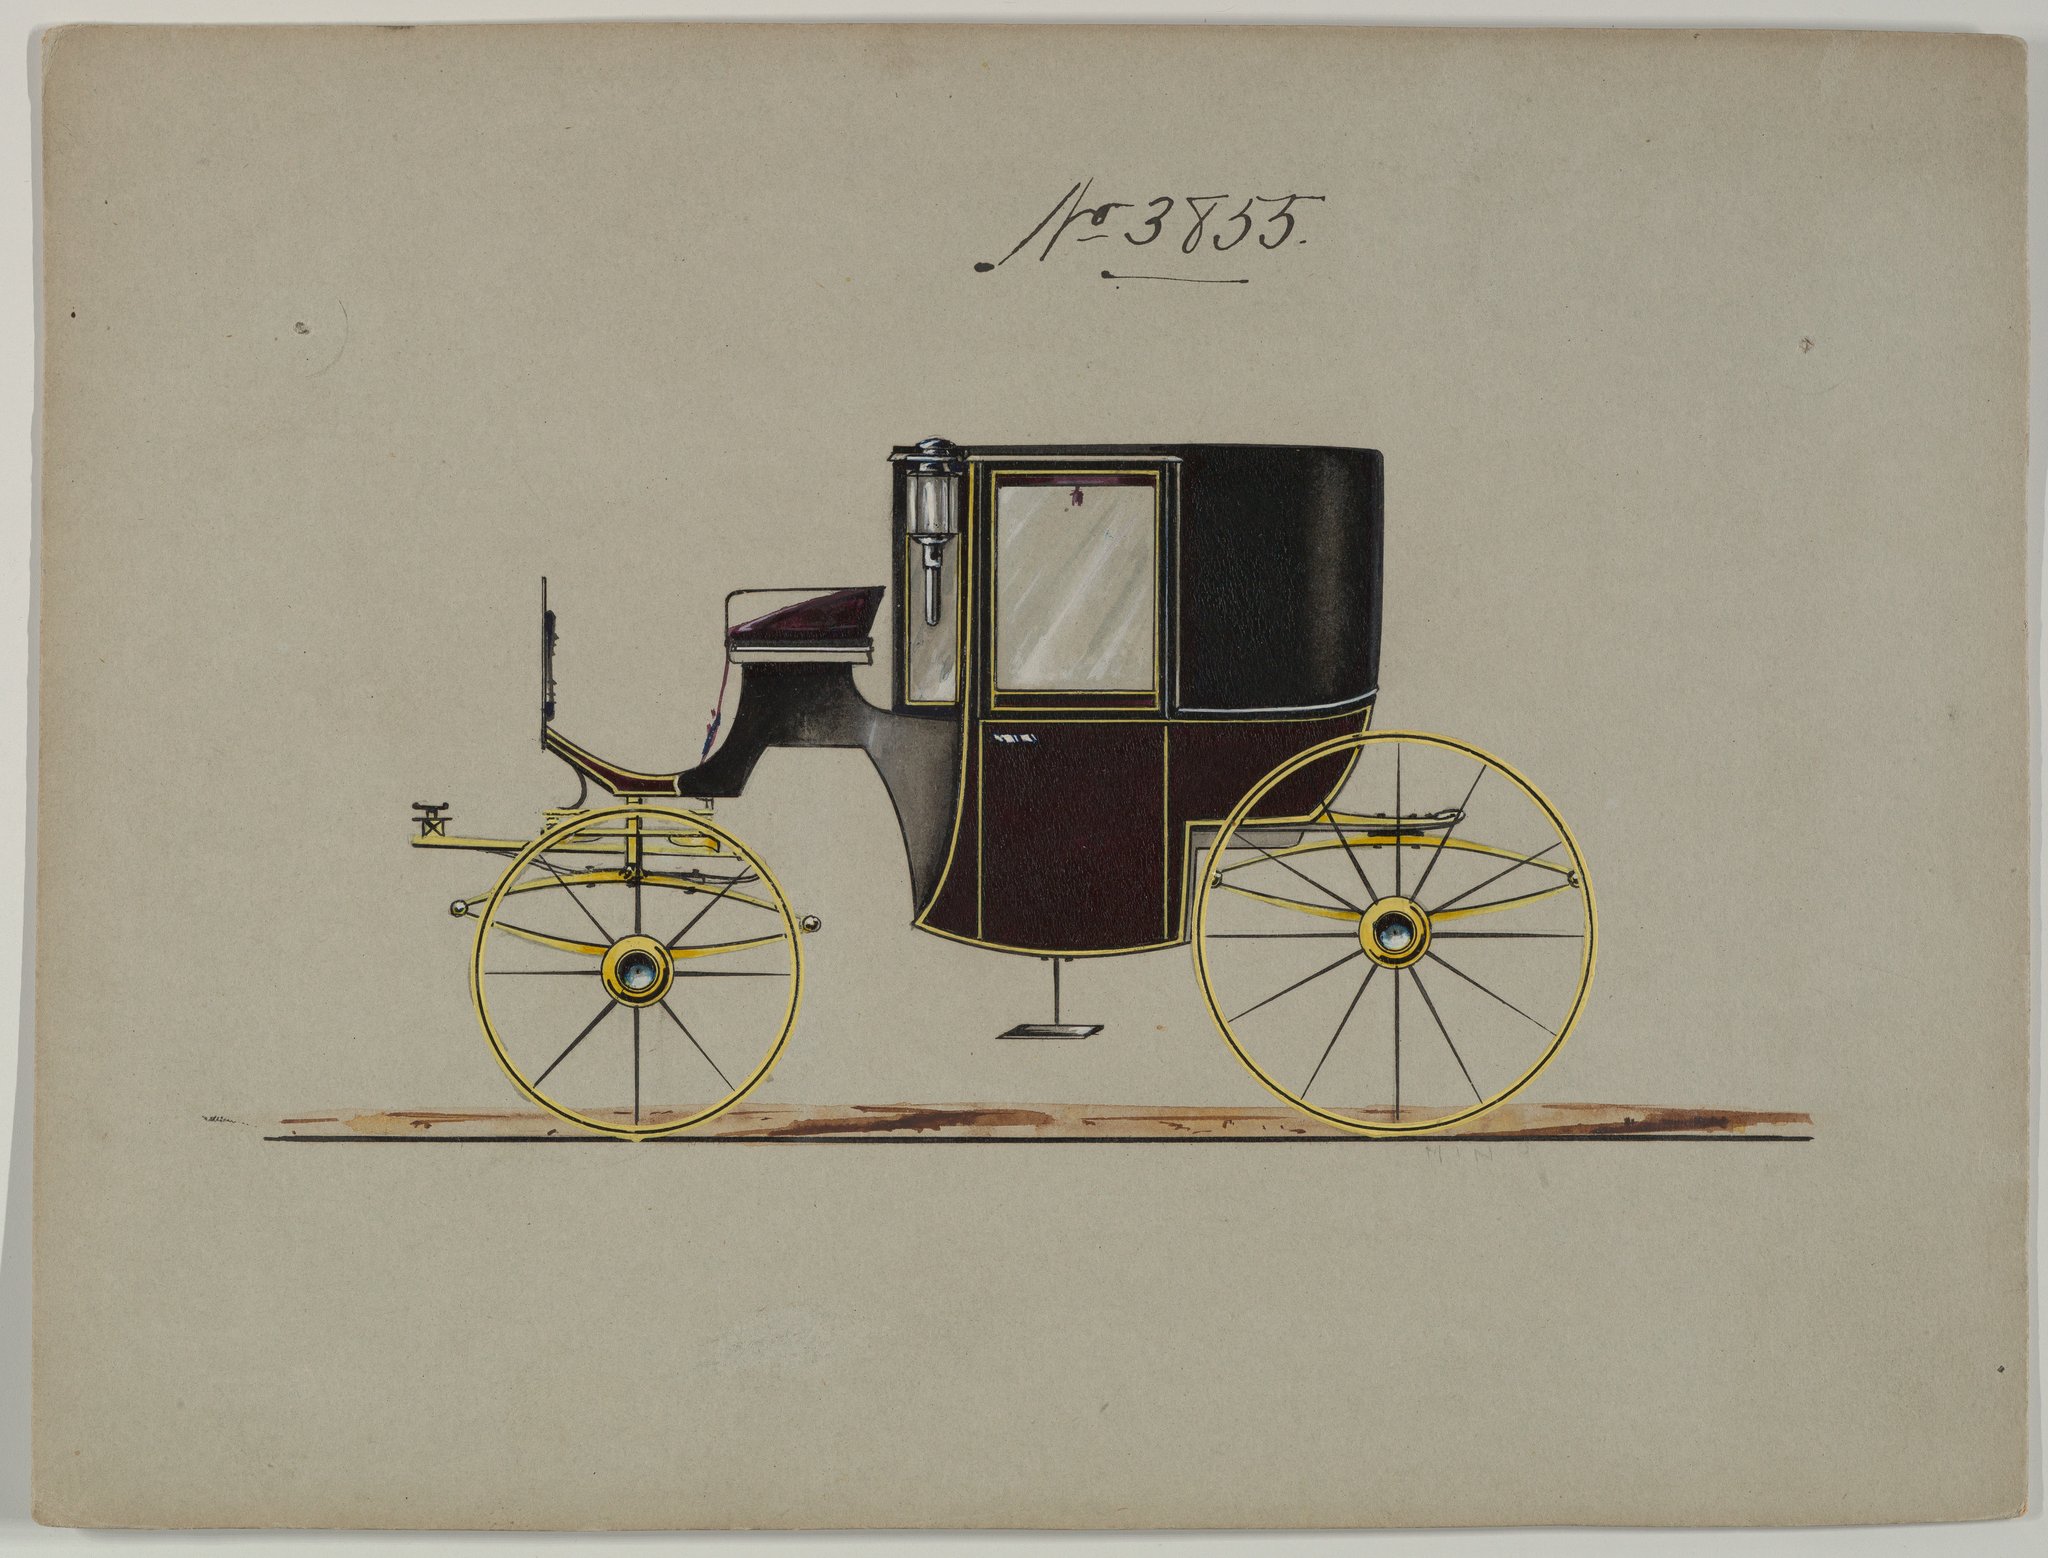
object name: drawing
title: Design for Coupé, no. 3855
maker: brewster & co.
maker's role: manufacturer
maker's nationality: american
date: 1883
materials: gouache, gum arabic, ink, watercolor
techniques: pen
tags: carriages